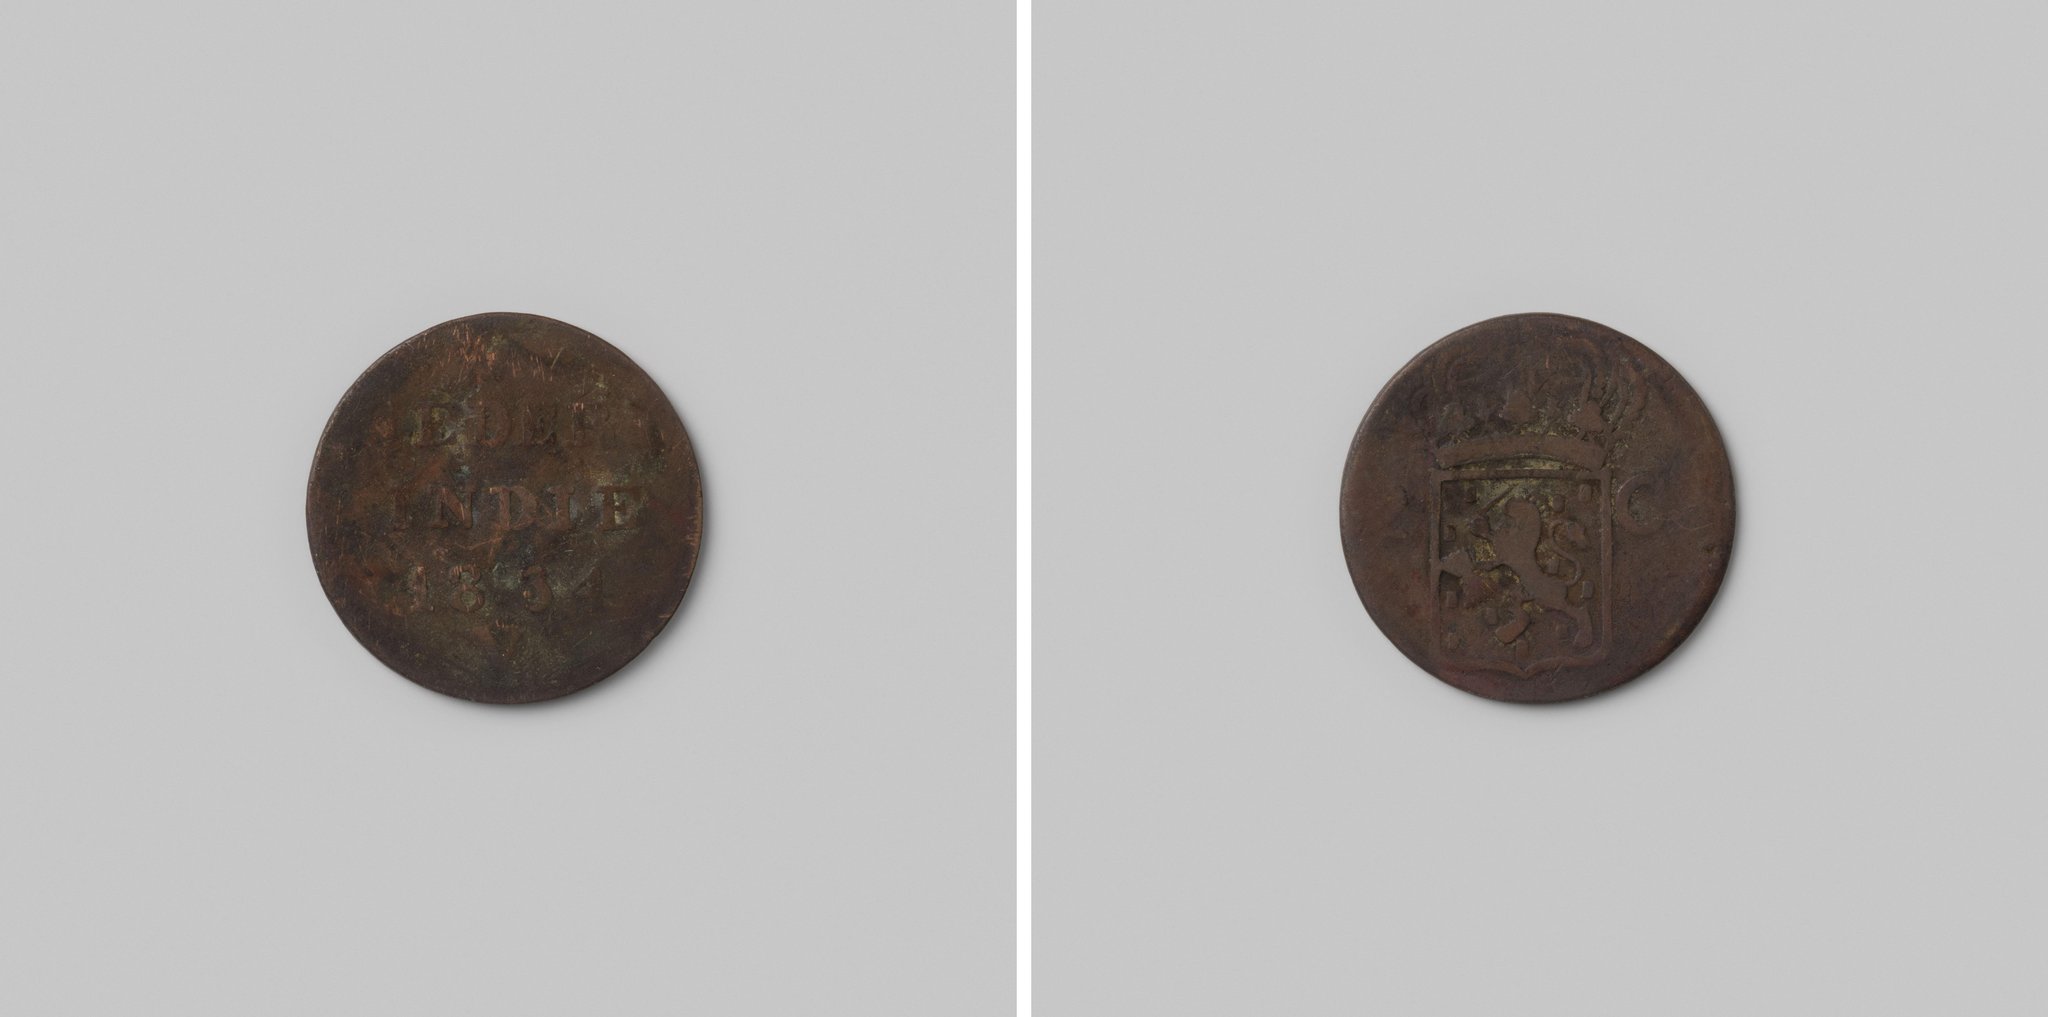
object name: coin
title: Koperen VOC-munt uit 1834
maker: Anonymous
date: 1834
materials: copper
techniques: striking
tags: dutch east indies, the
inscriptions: inscription: ‘C’, inscription: ‘B.A. Seaby, LTD. / Numismatists, / 65, Great Portland Street, / London, W.1’, inscription: ‘* NEDERL / INDIE / 1834’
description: Koperen VOC-muntje uit 1834 uit Nederlands-Indië. Voorzijde: opschrift. Keerzijde: wapen met leeuw erin, rechts ervan een C. Het muntje zit in een vierkant envelopje met opschrift.